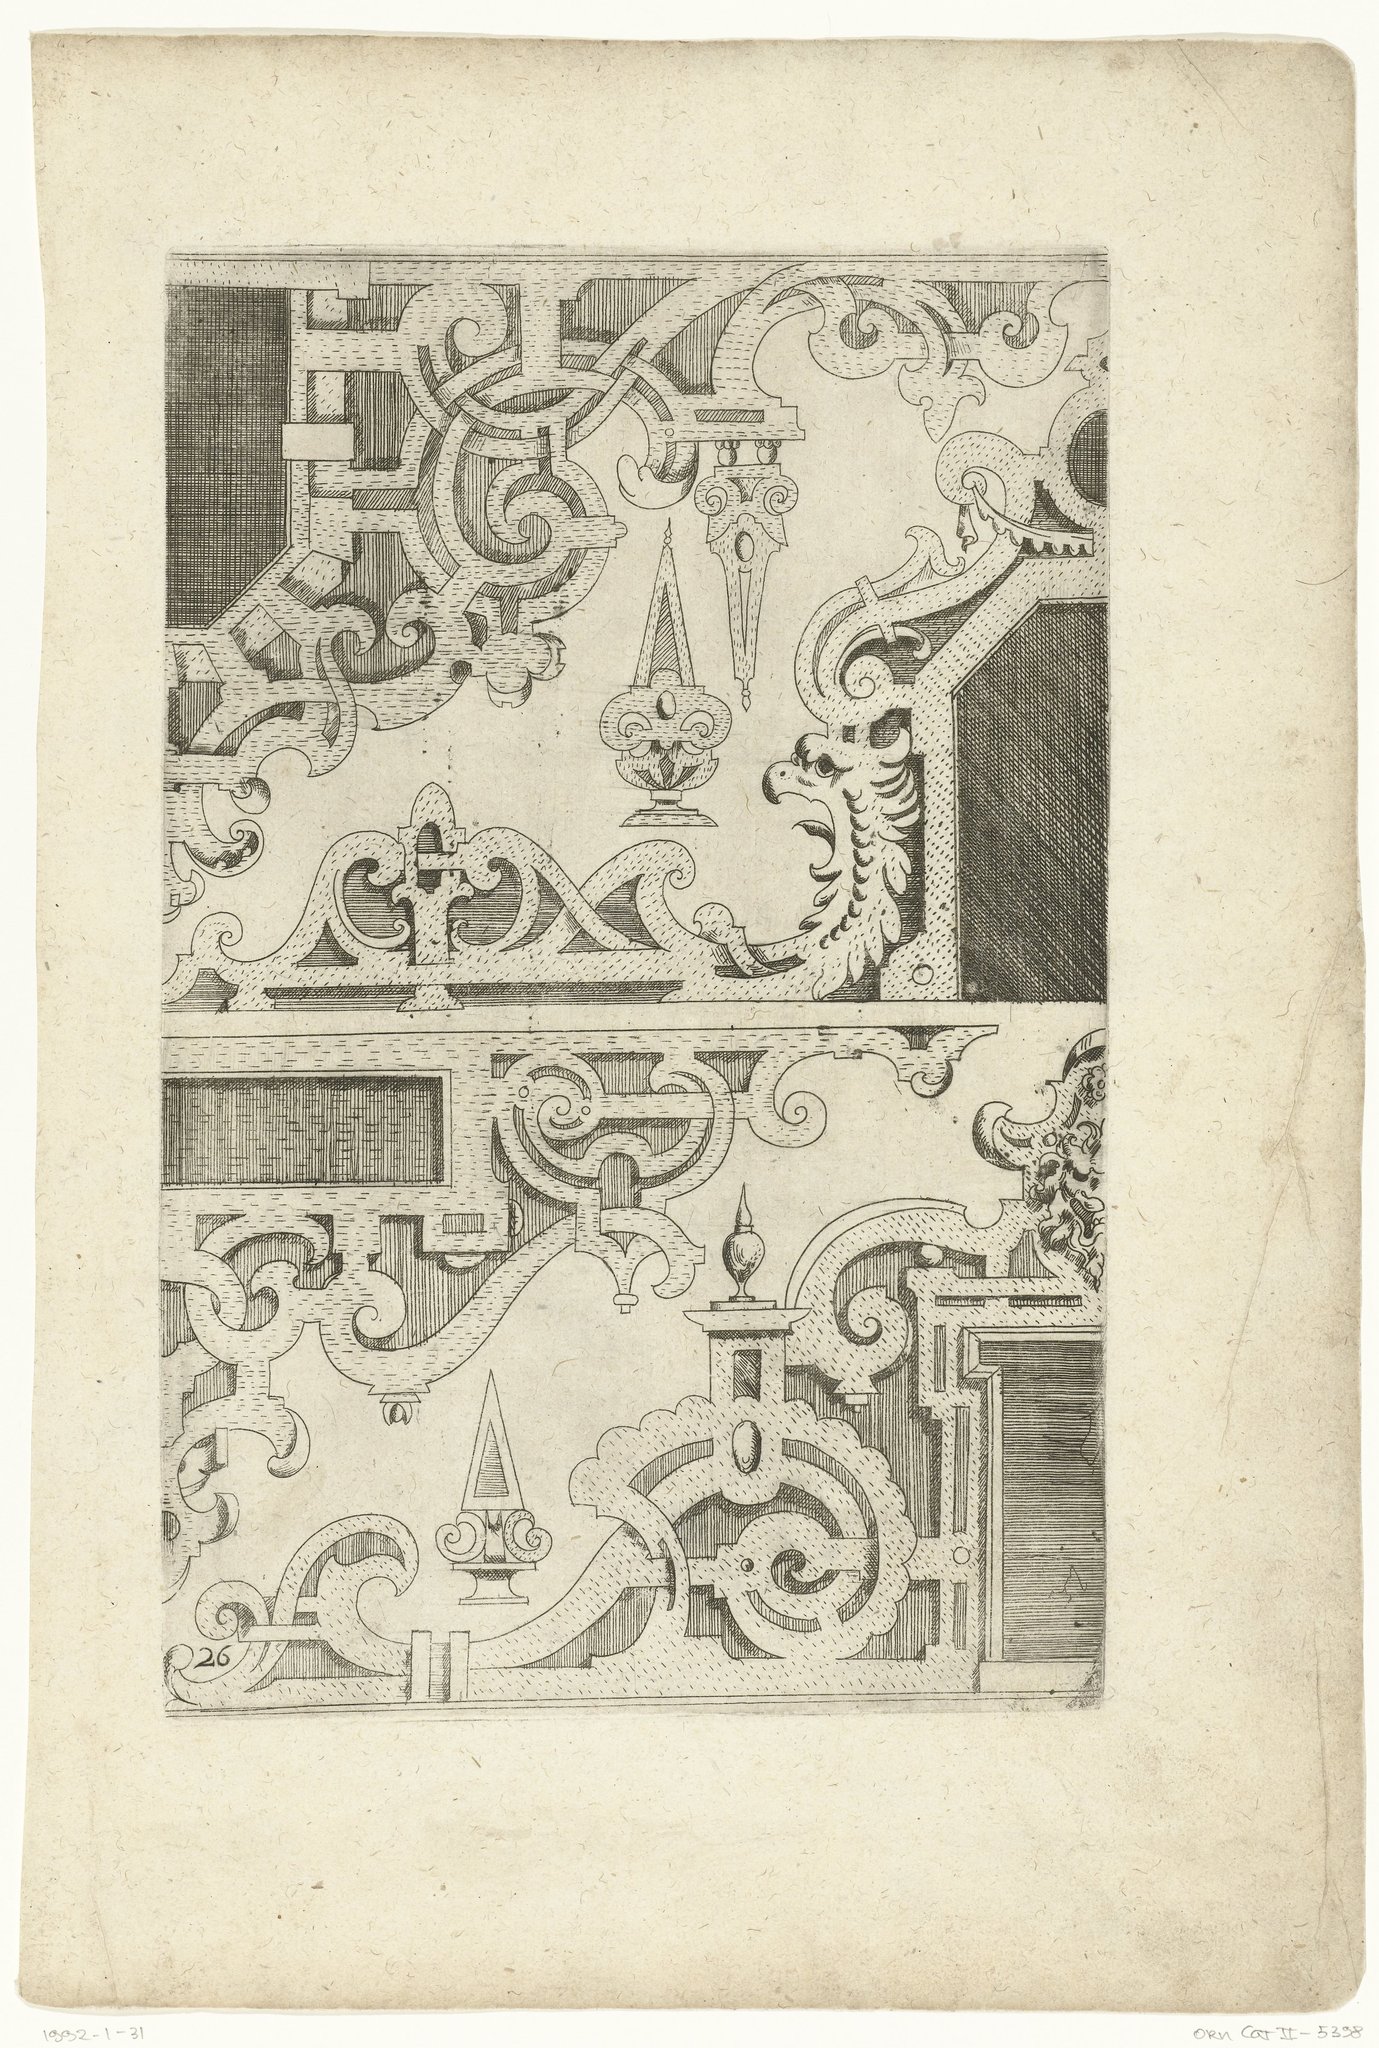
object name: print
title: Twee helften van lijsten en twee helften van kroonelementen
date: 1610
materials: paper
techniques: etching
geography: germany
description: Lijsten en kroonelementen in de vorm van een driehoek, met lege tabletten. Blad 26 uit serie van titelblad en 28 bladen.